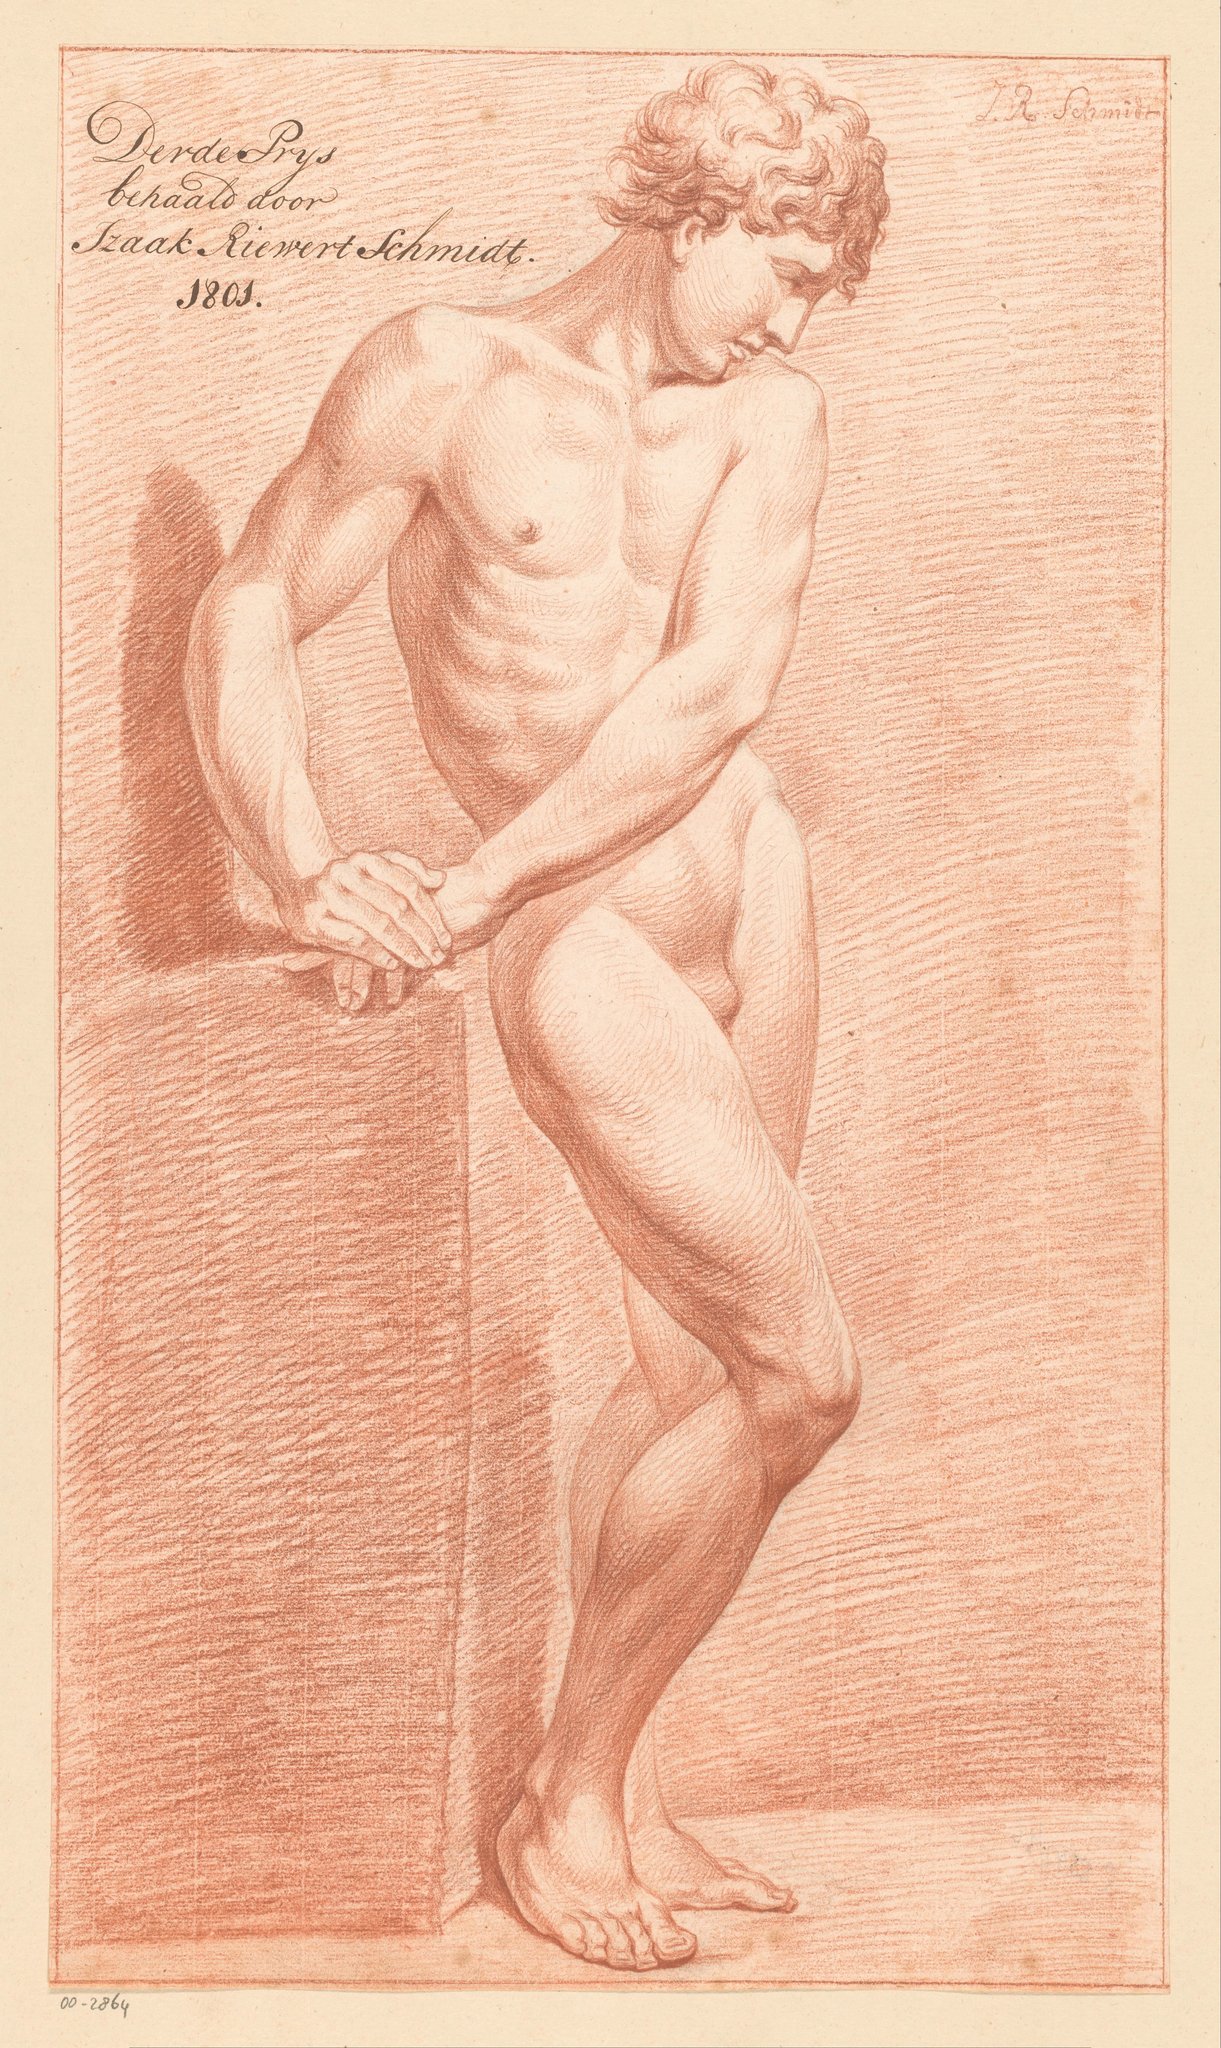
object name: drawing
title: Staand mannelijk naakt, van opzij gezien (3e prijs 1801)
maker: izaak riewert schmidt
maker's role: draughtsman, print maker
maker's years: 1781-1826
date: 1801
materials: chalk, charcoal, paper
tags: standing figure (+ nude human being)